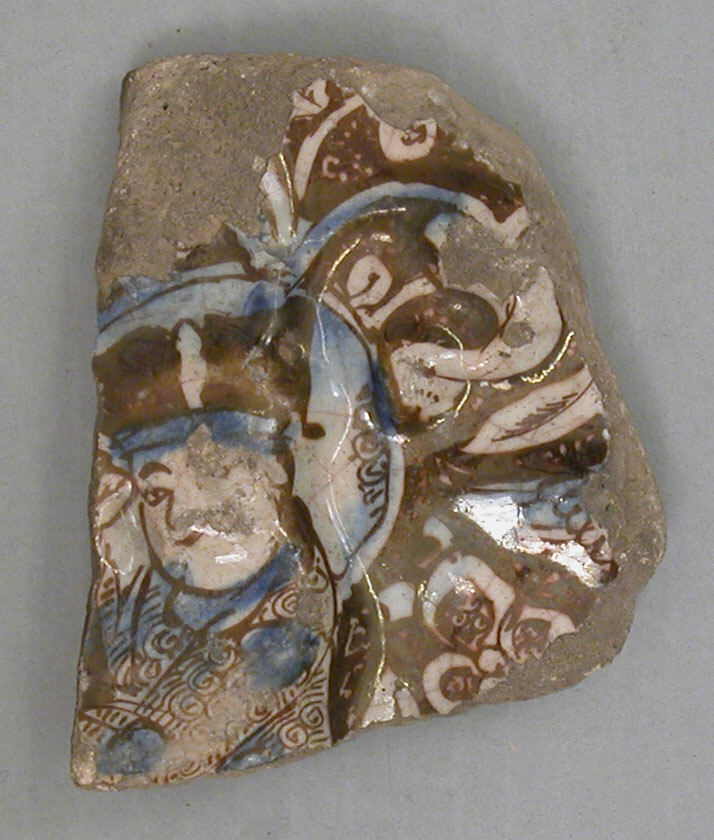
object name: tile fragment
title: Tile Fragments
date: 1201-1300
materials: stonepaste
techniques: glazing, luster painting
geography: iran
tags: faces